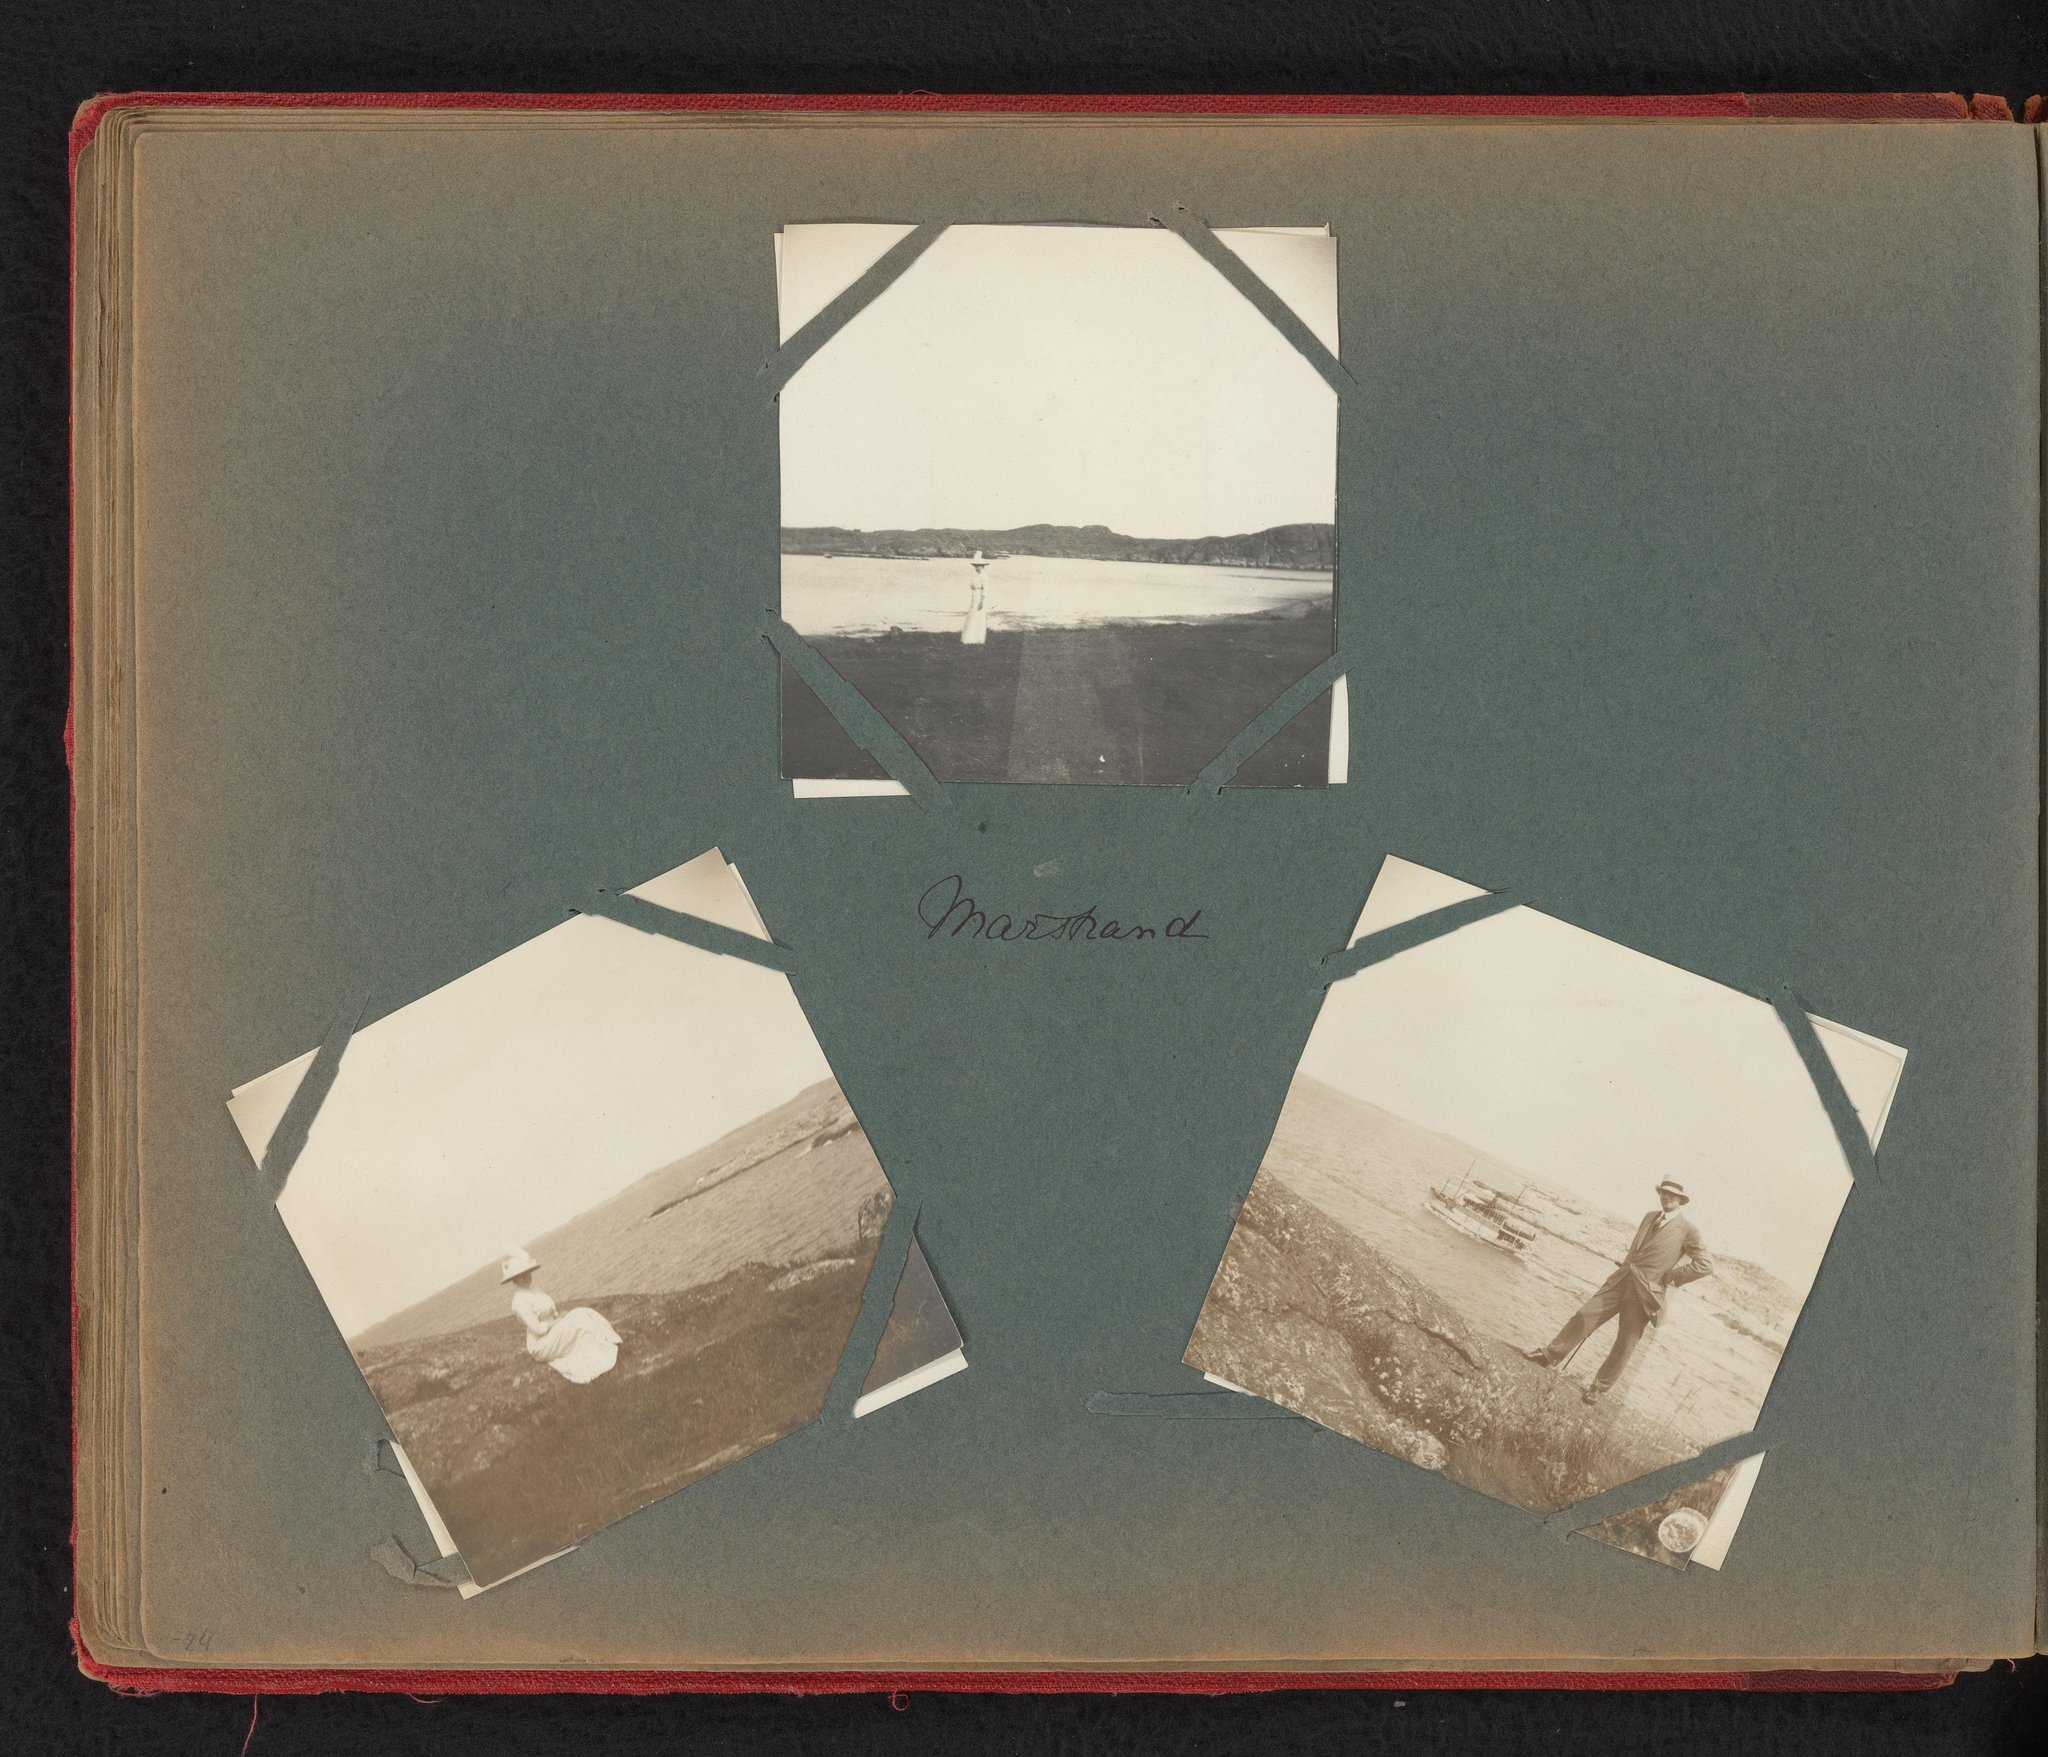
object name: album leaf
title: Joan en Charlotte Boelen in Marstrand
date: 1912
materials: paper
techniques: gelatin silver print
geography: marstrand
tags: charlotte alida boelen-matthes (lot), amsterdam, joan gerard boelen, coast, sea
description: Deze foto's zijn onderdeel van een album.